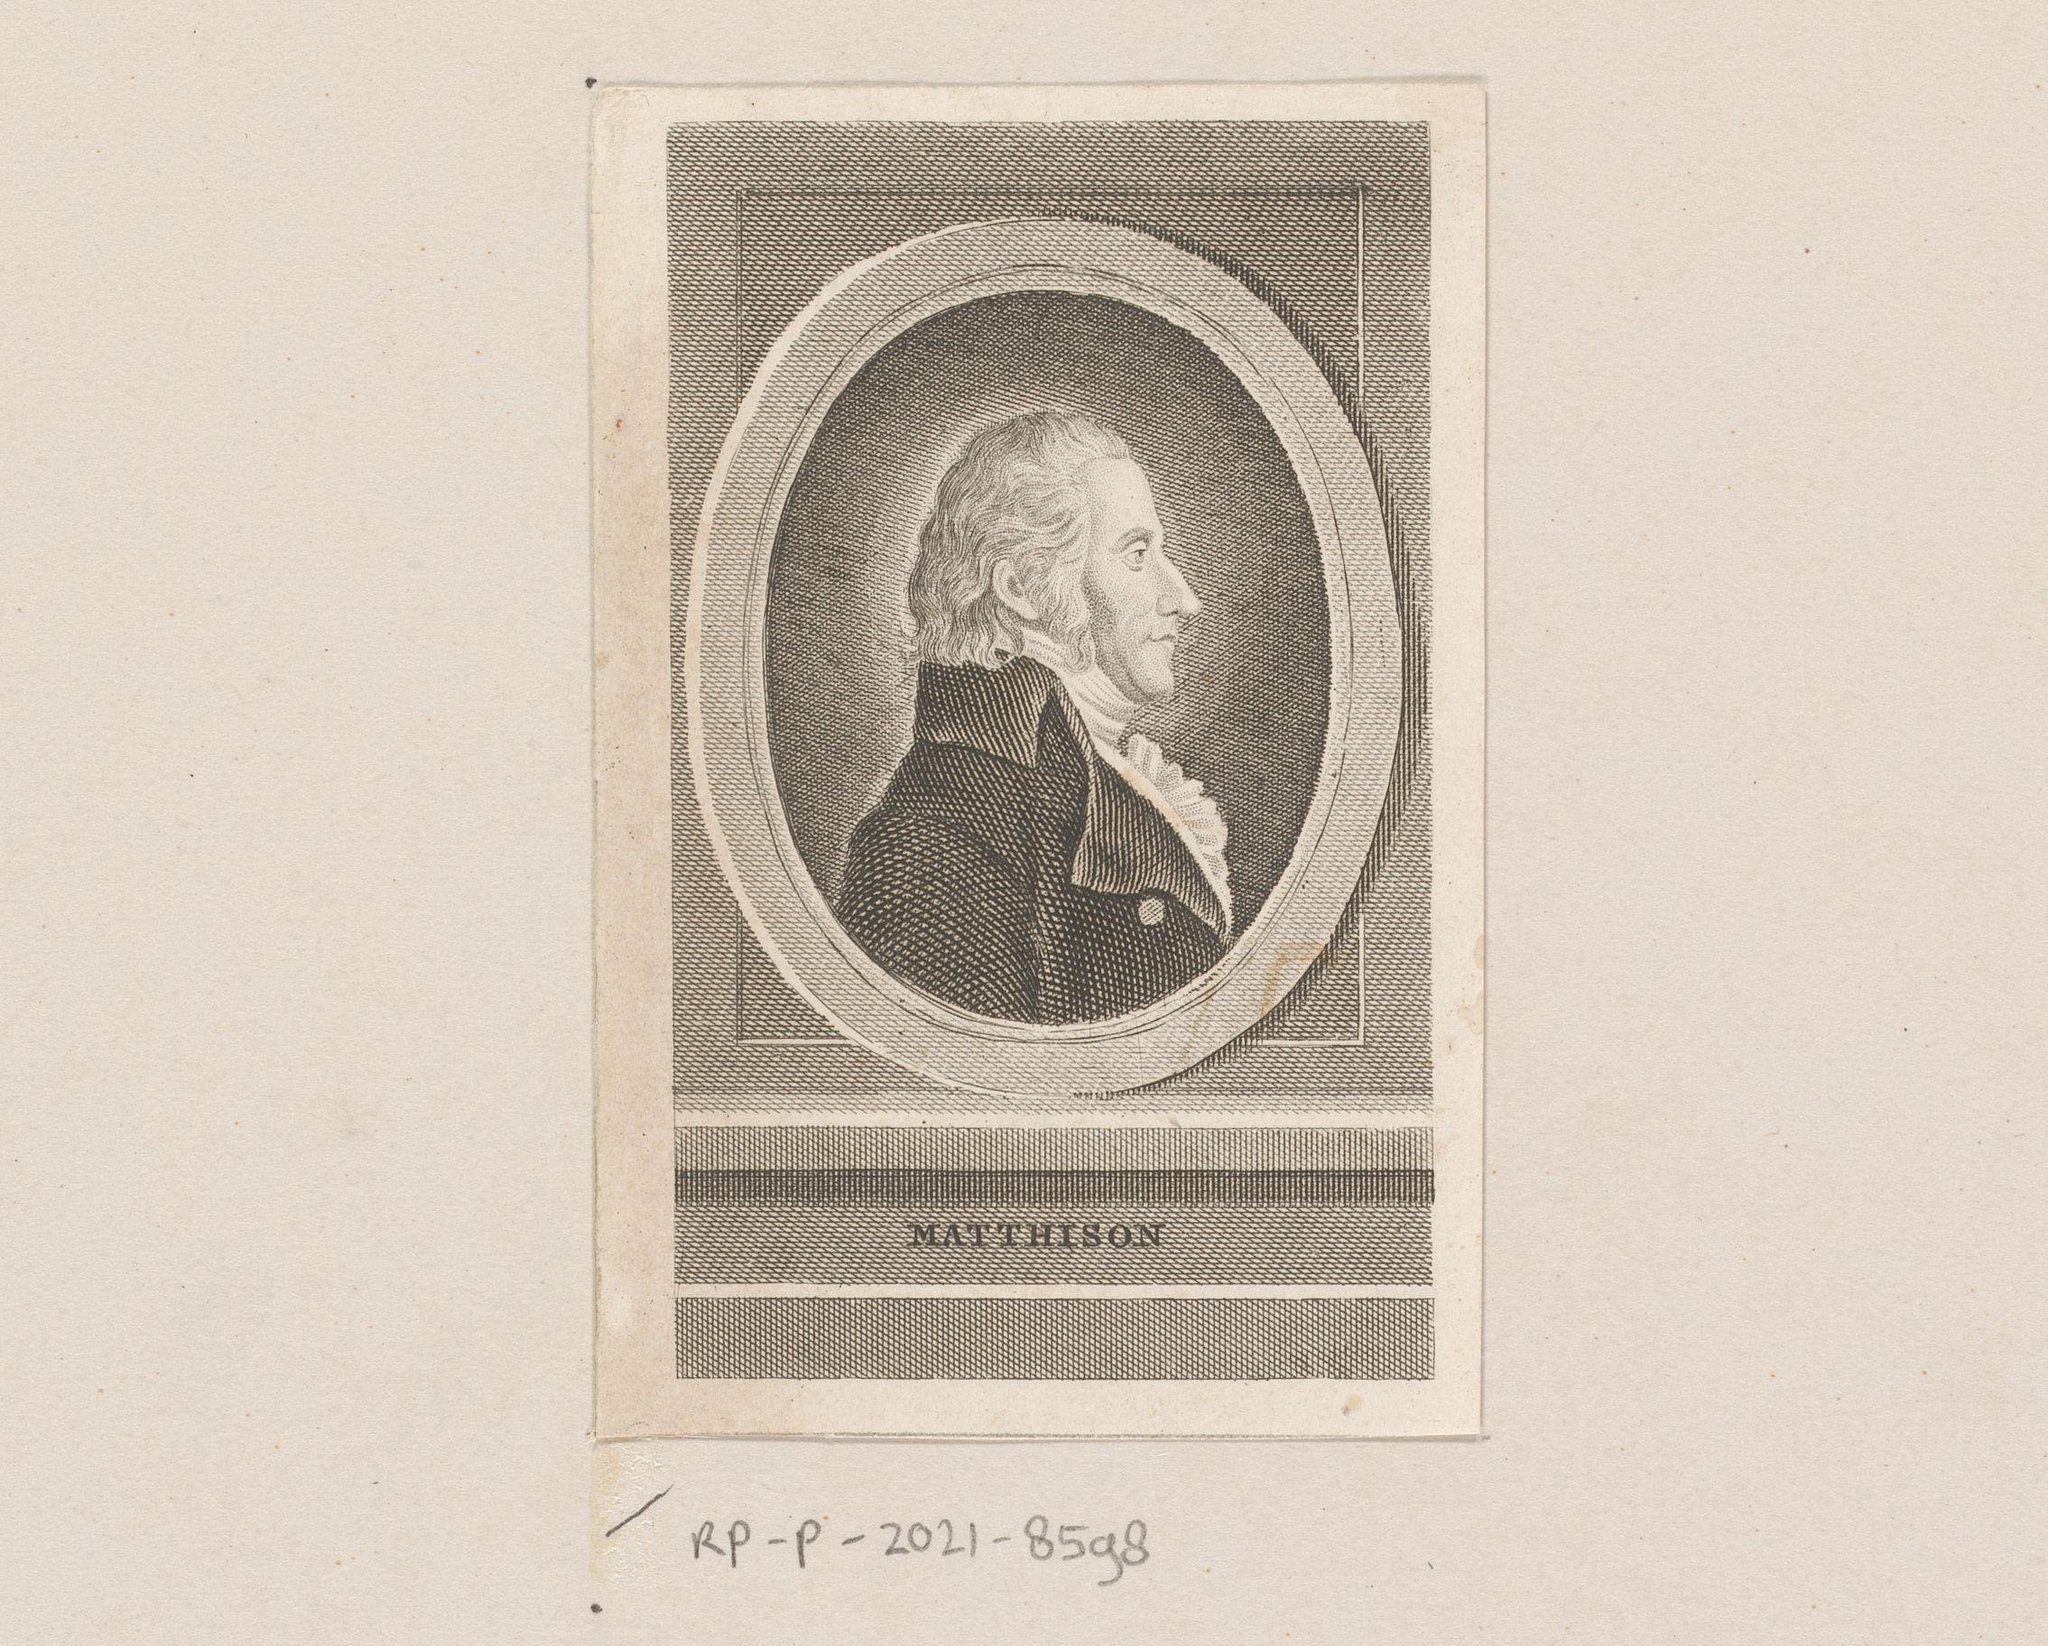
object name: print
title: Portret van Friedrich von Matthisson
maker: Anonymous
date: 1790-1830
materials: paper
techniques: etching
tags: ornament ~ medallion, historical persons, portrait of a writer